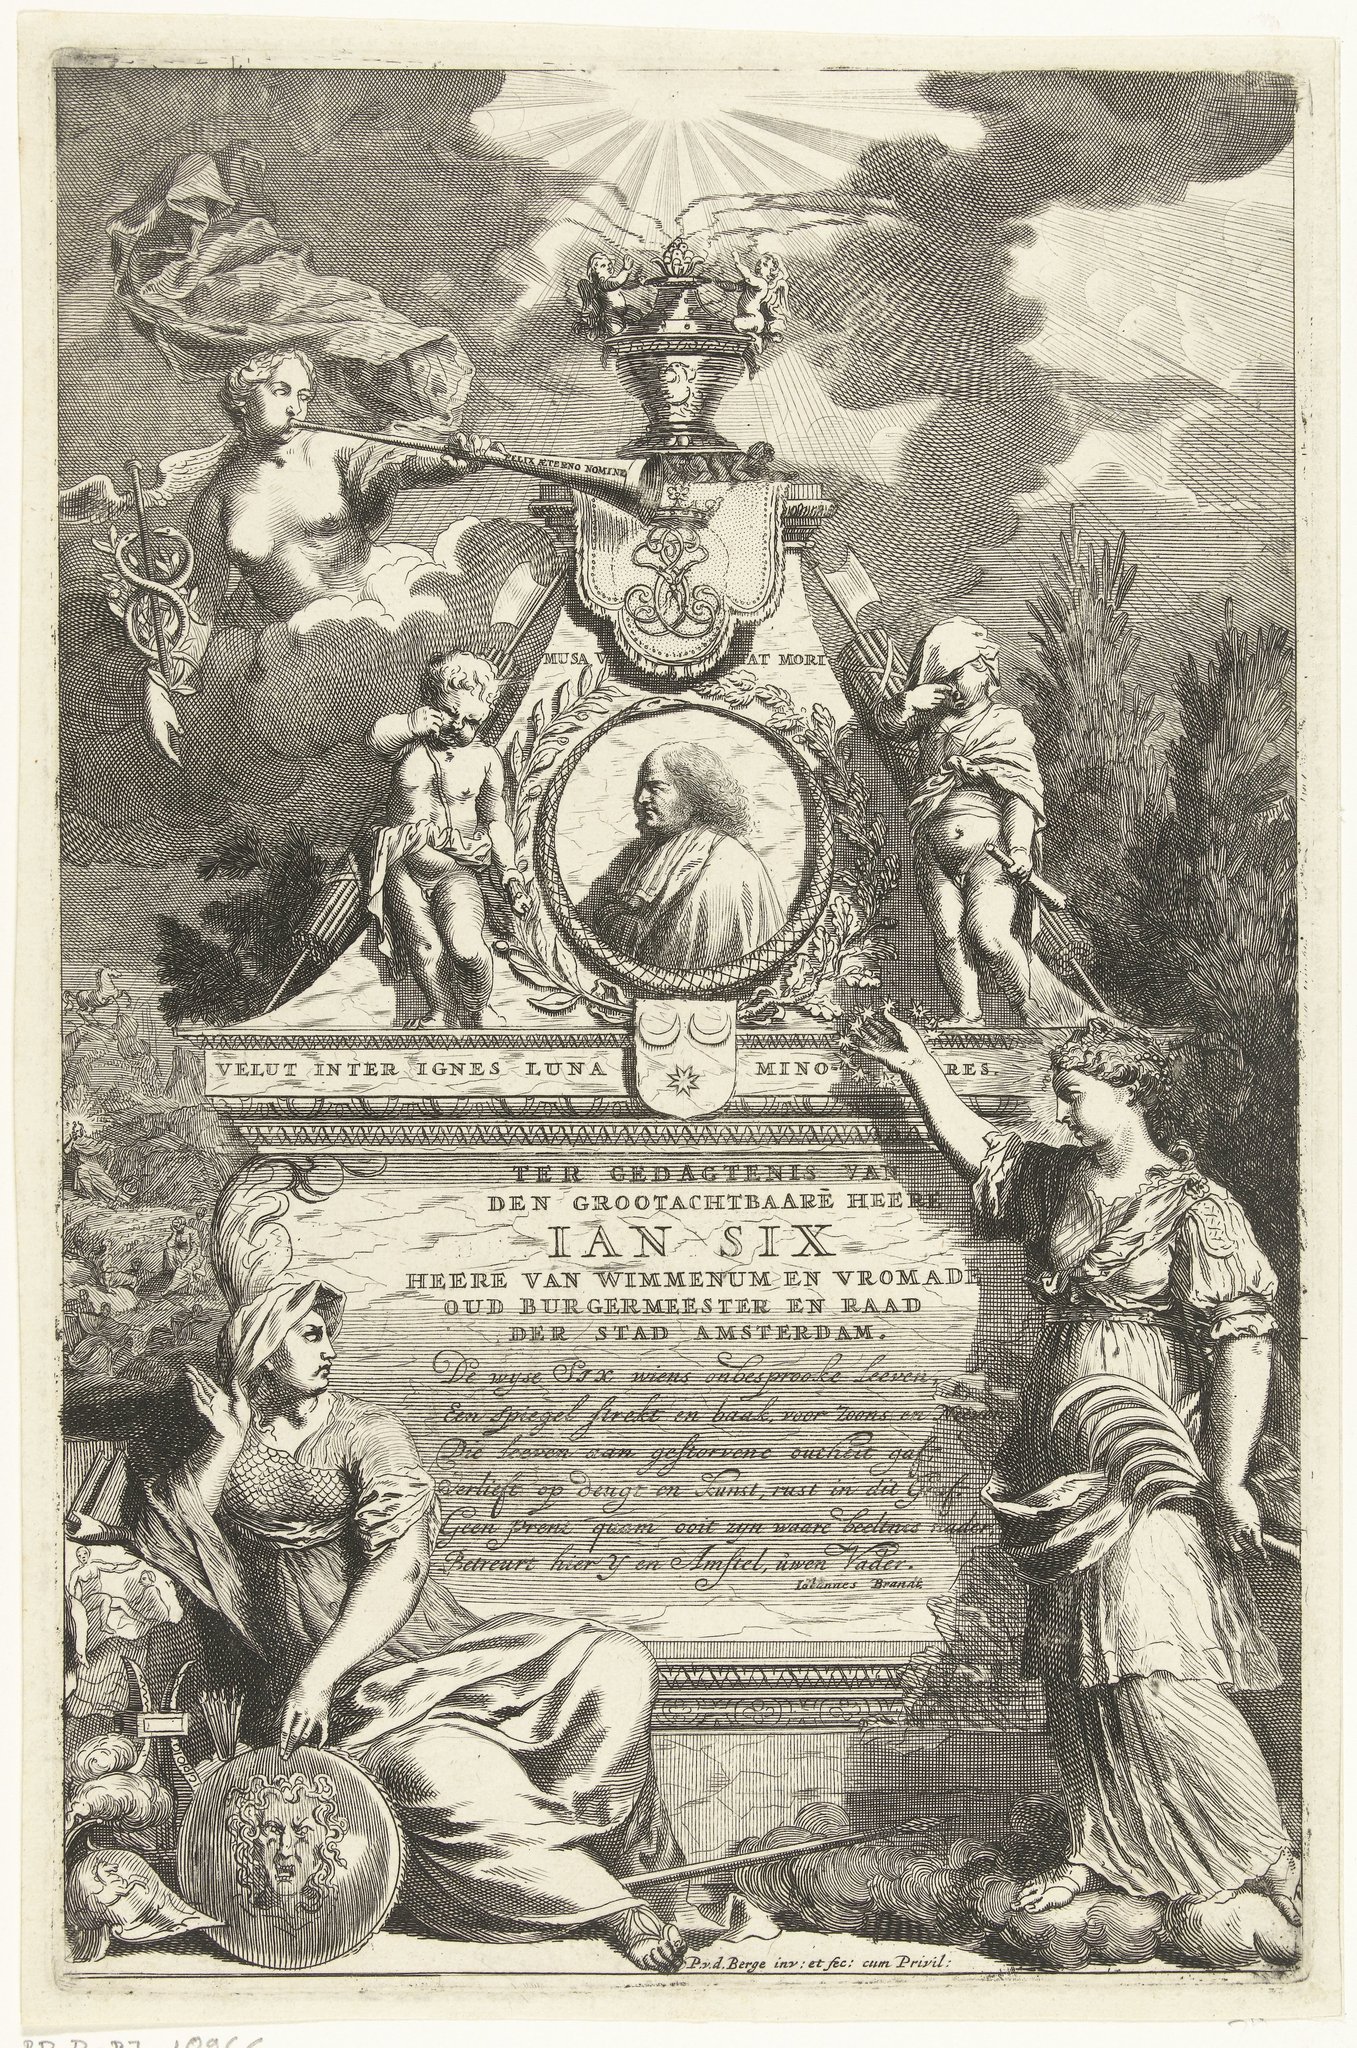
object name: print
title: Grafmonument voor Jan Six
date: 1700-1702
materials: paper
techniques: engraving, etching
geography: amsterdam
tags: amsterdam, mayor, jan six (1618-1700), grave-building, monumental tomb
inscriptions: collector's mark: Lugt 2228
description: Grafmonument voor Jan Six met een plaquette met een portret van Six en profiel. Boven het portret zijn monogram op een vaandel, onder zijn wapen. Op de stenen sokkel een tekst van zes regels op het leven van Six door Johannes Brandt.